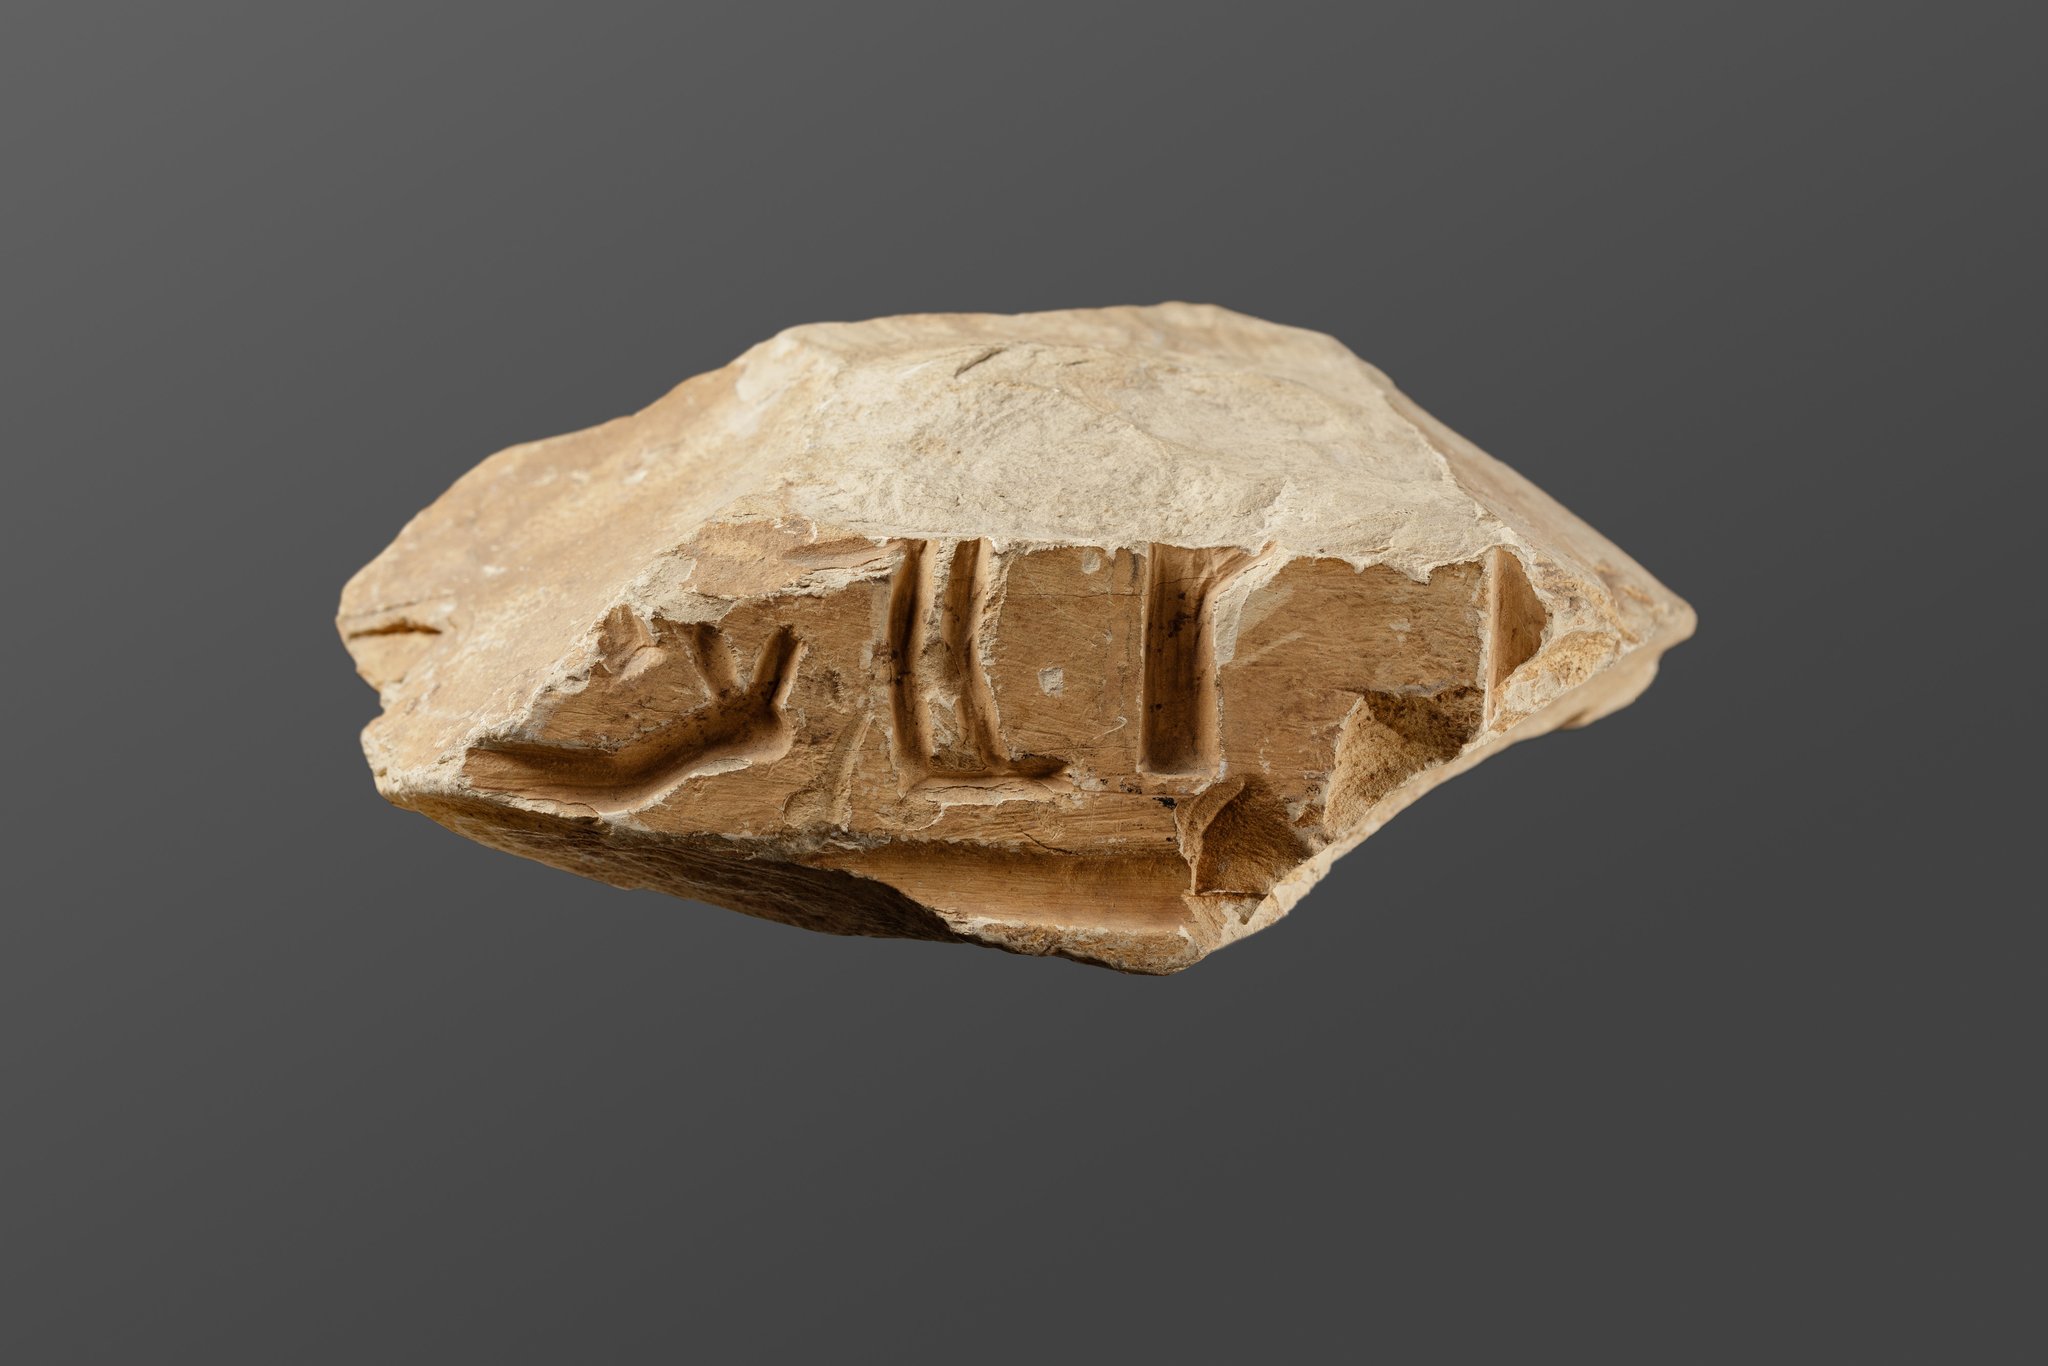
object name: relief fragment 47, tomb of mereri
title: Relief fragment possibly from the tomb of Mereri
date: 2100-2090 BCE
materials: stone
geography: egypt